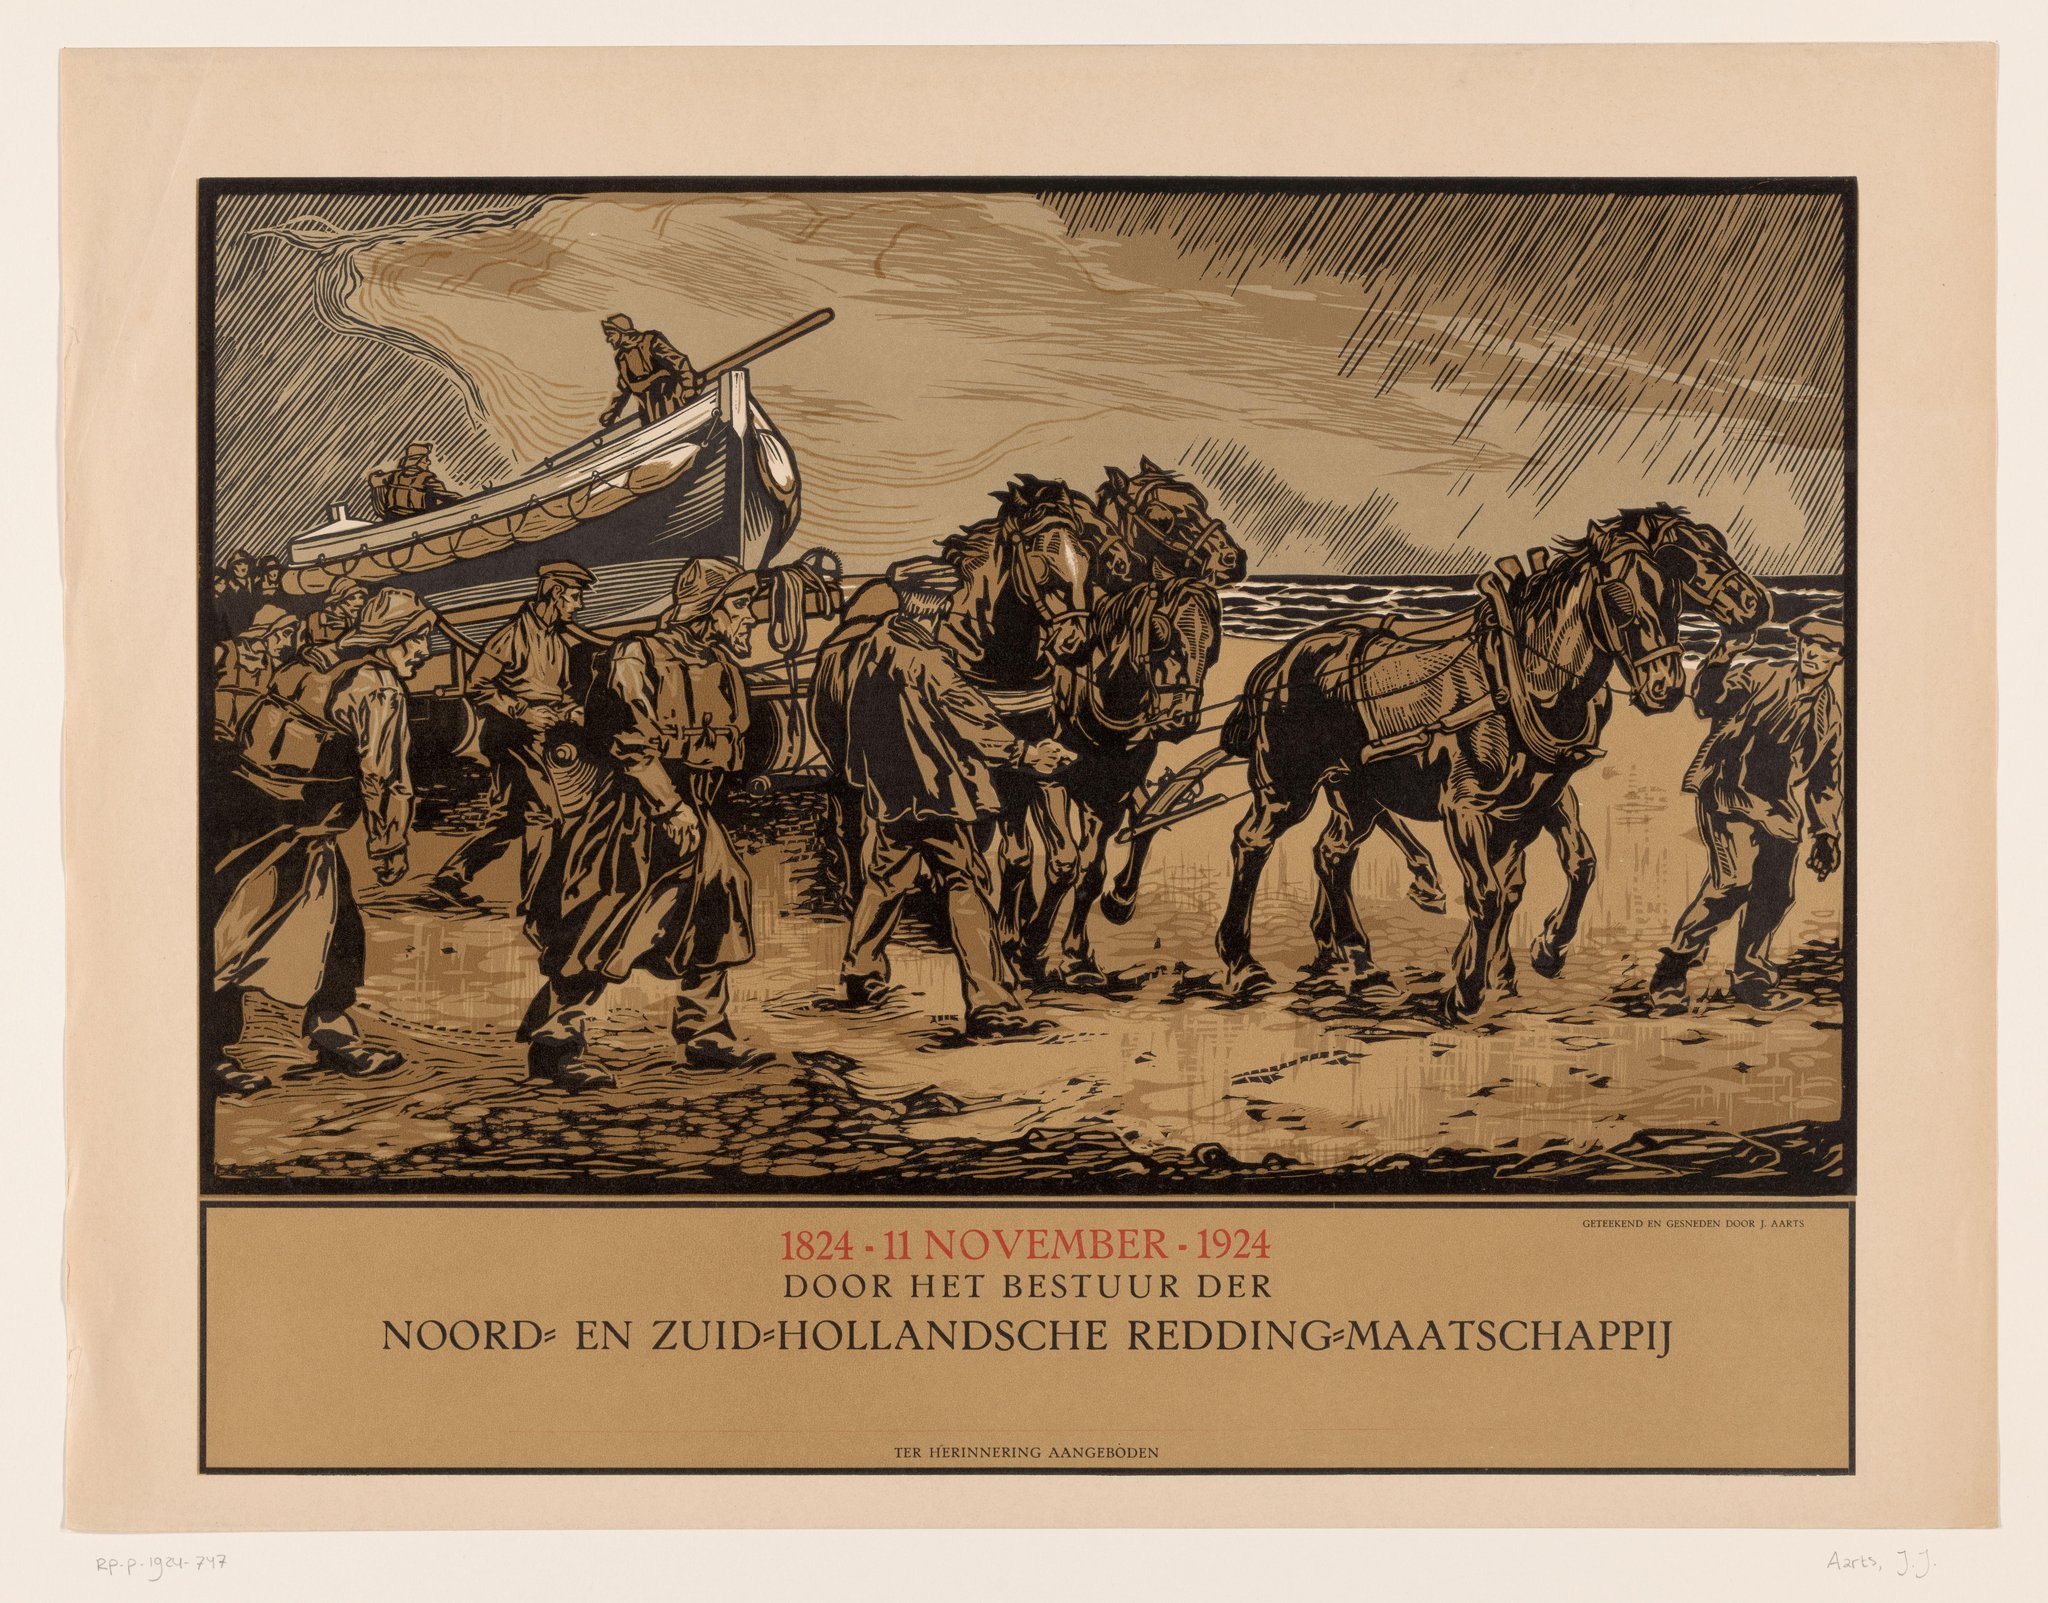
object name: gelegenheidsgrafiek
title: Jubileumprent van de Noord- en Zuid-Hollandsche Redding-Maatschappij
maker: johannes josephus aarts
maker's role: draughtsman, print maker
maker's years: 1871-1934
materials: paper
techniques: letterpress printing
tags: lifeboat, horse in motion, coast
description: Voorgespannen paarden trekken een reddingsboot. Daaromheen reddingswerkers. Prent naar aanleiding van het honderdjarig bestaan van de Noord- en Zuid-Hollandsche Redding-Maatschappij. Onderaan de tekst: 1824 - 11 november - 1924; Door het bestuur der Noord- en Zuid-Hollandsche Redding-Maatschappij ter herinnering aangeboden.